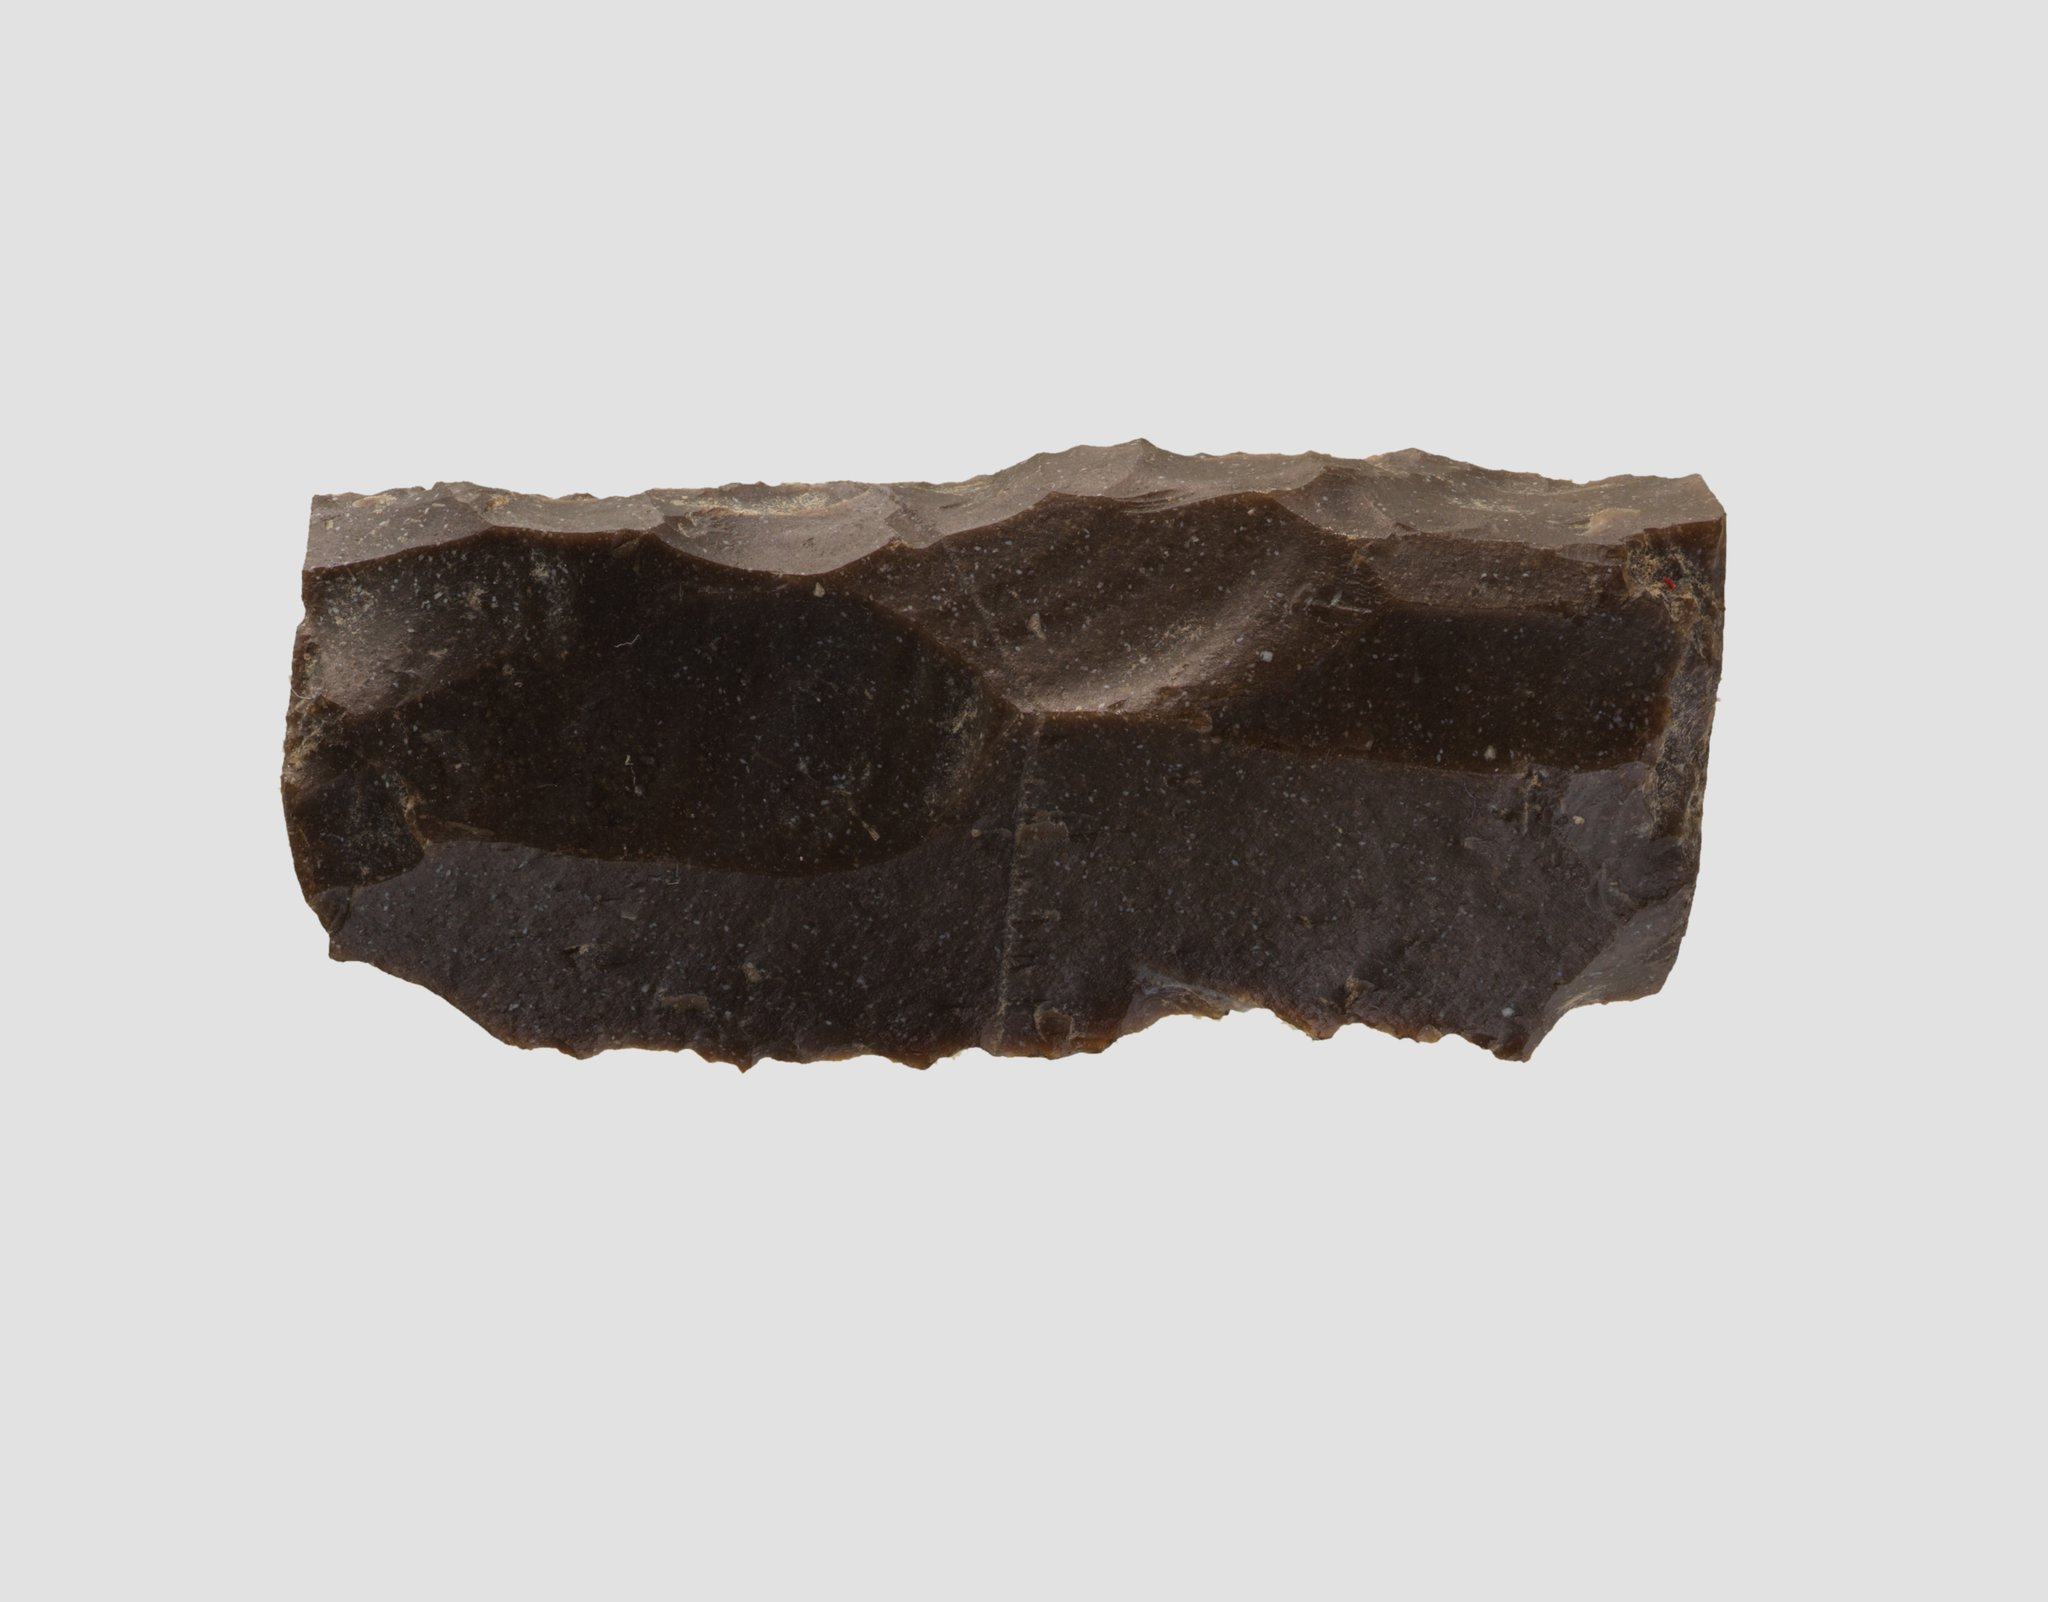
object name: knife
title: Blade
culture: ghassulian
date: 4600-3600 BCE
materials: stone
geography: levant